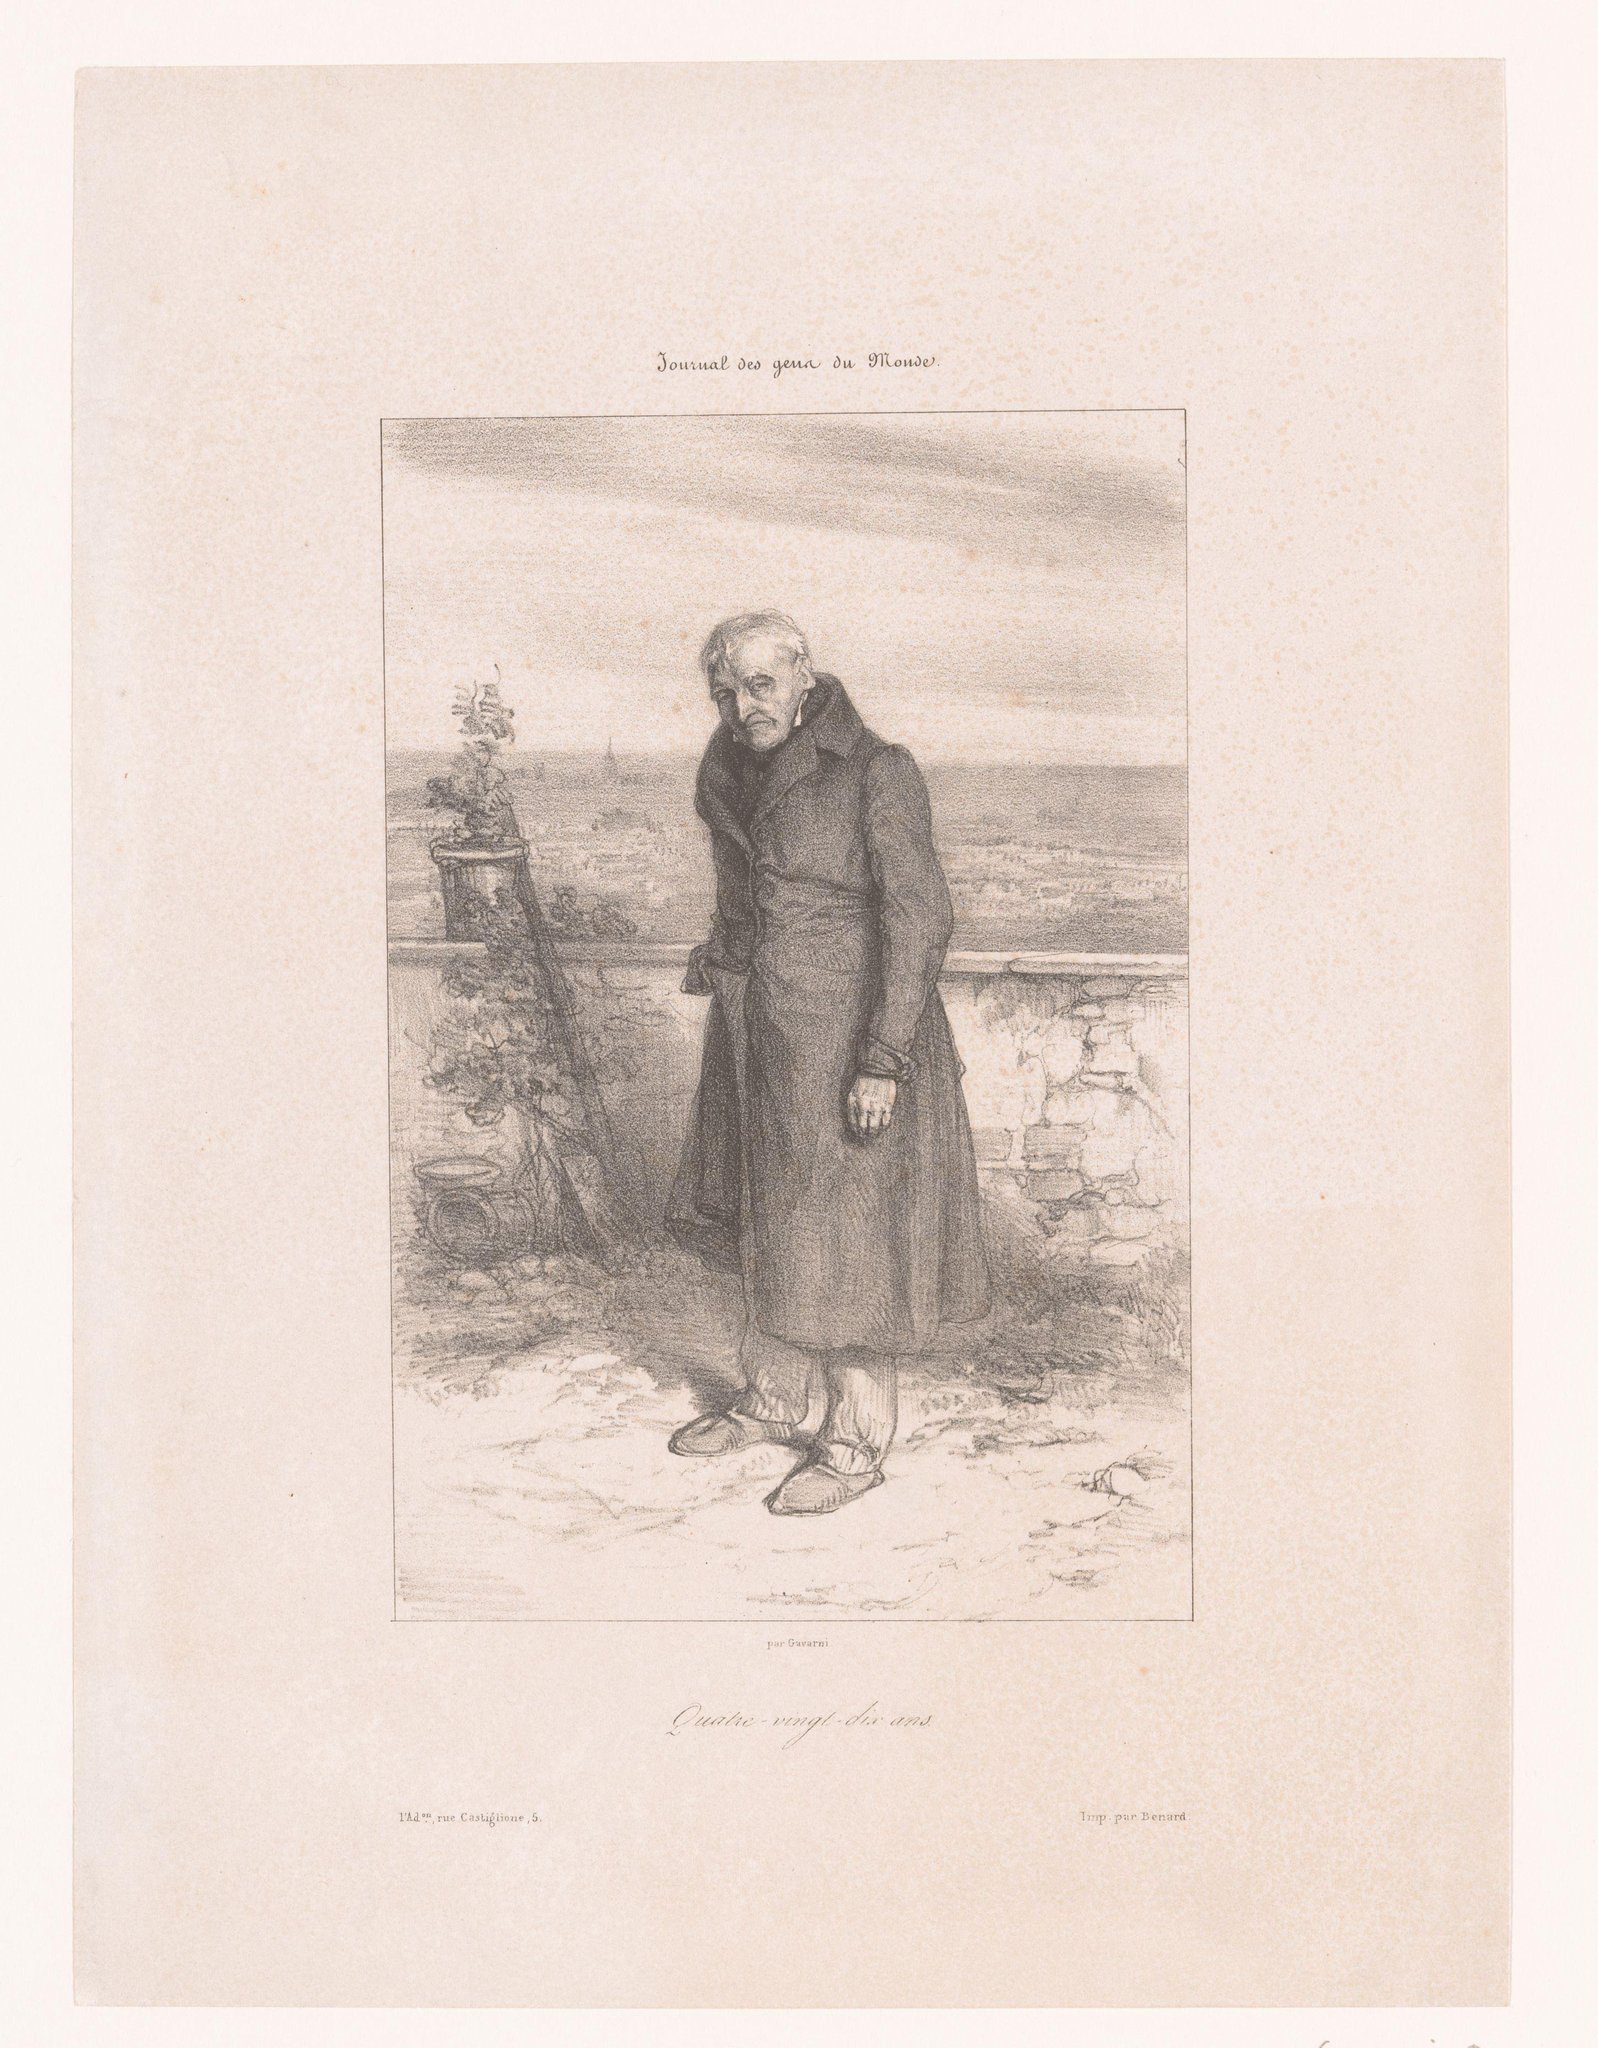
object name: print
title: Quatre-vingt-dix ans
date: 1834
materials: paper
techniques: lithograph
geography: paris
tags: historical persons, old man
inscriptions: collector's mark: Lugt 2228a, collector's mark: Lugt 2760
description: Prent gebruikt voor: Journal des gens du Monde.